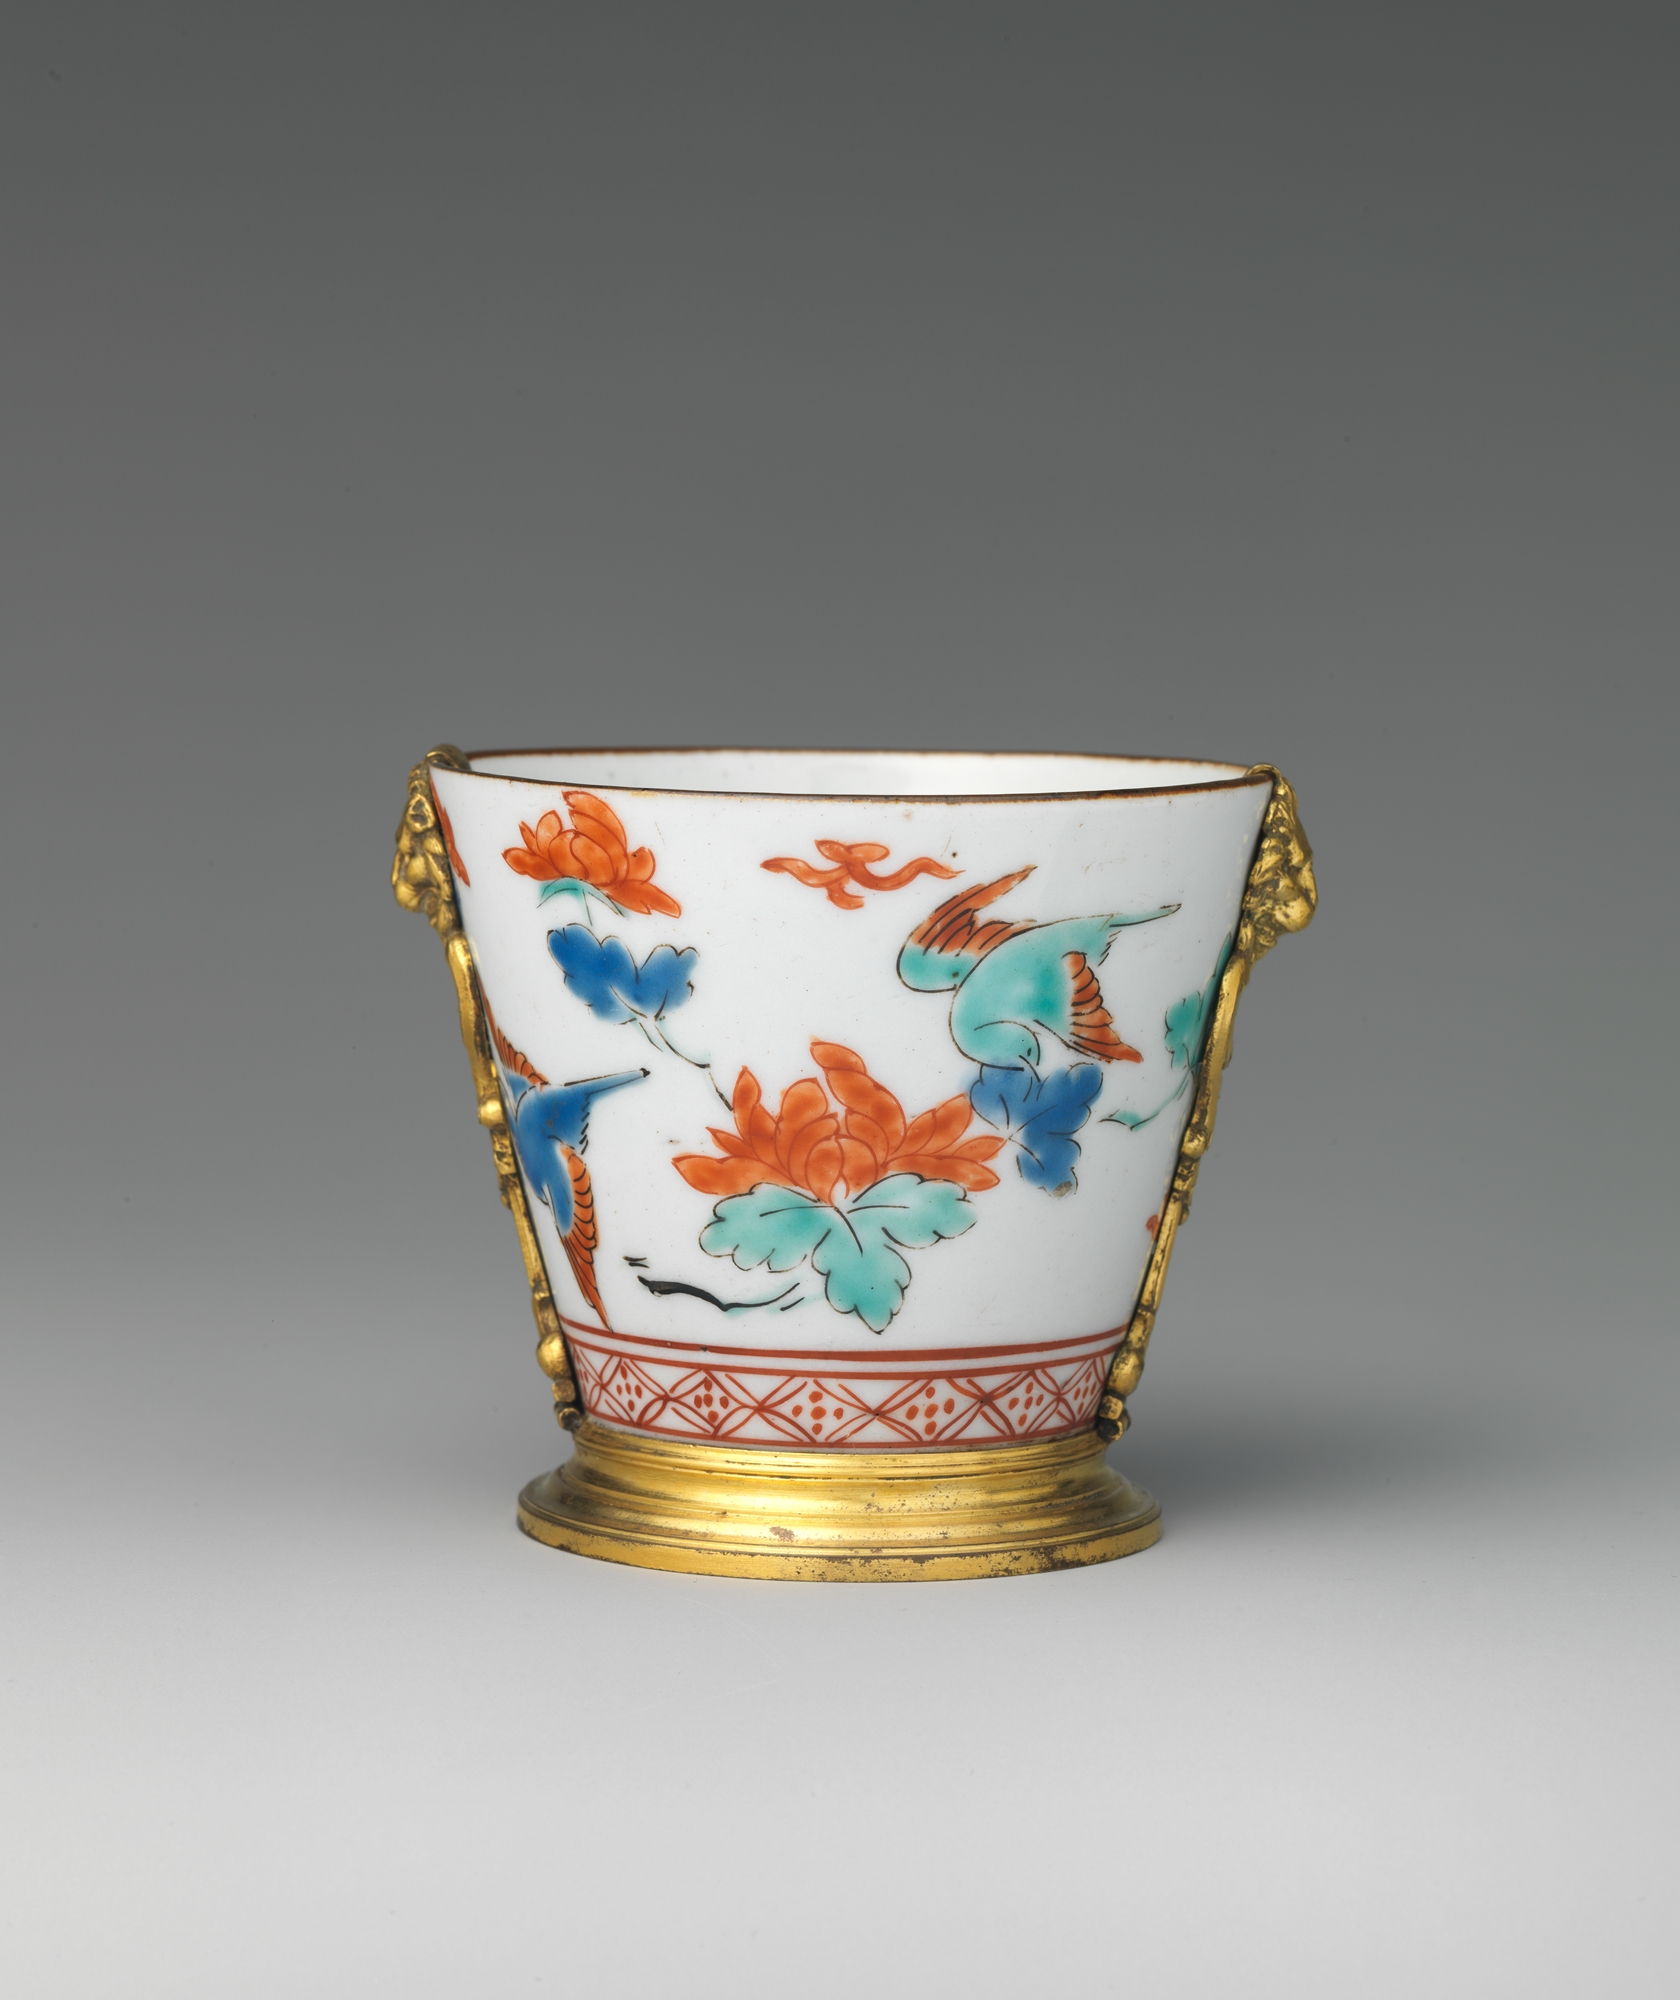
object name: cup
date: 1701-1800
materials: brass, gilt, hard paste porcelain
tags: birds,flowers